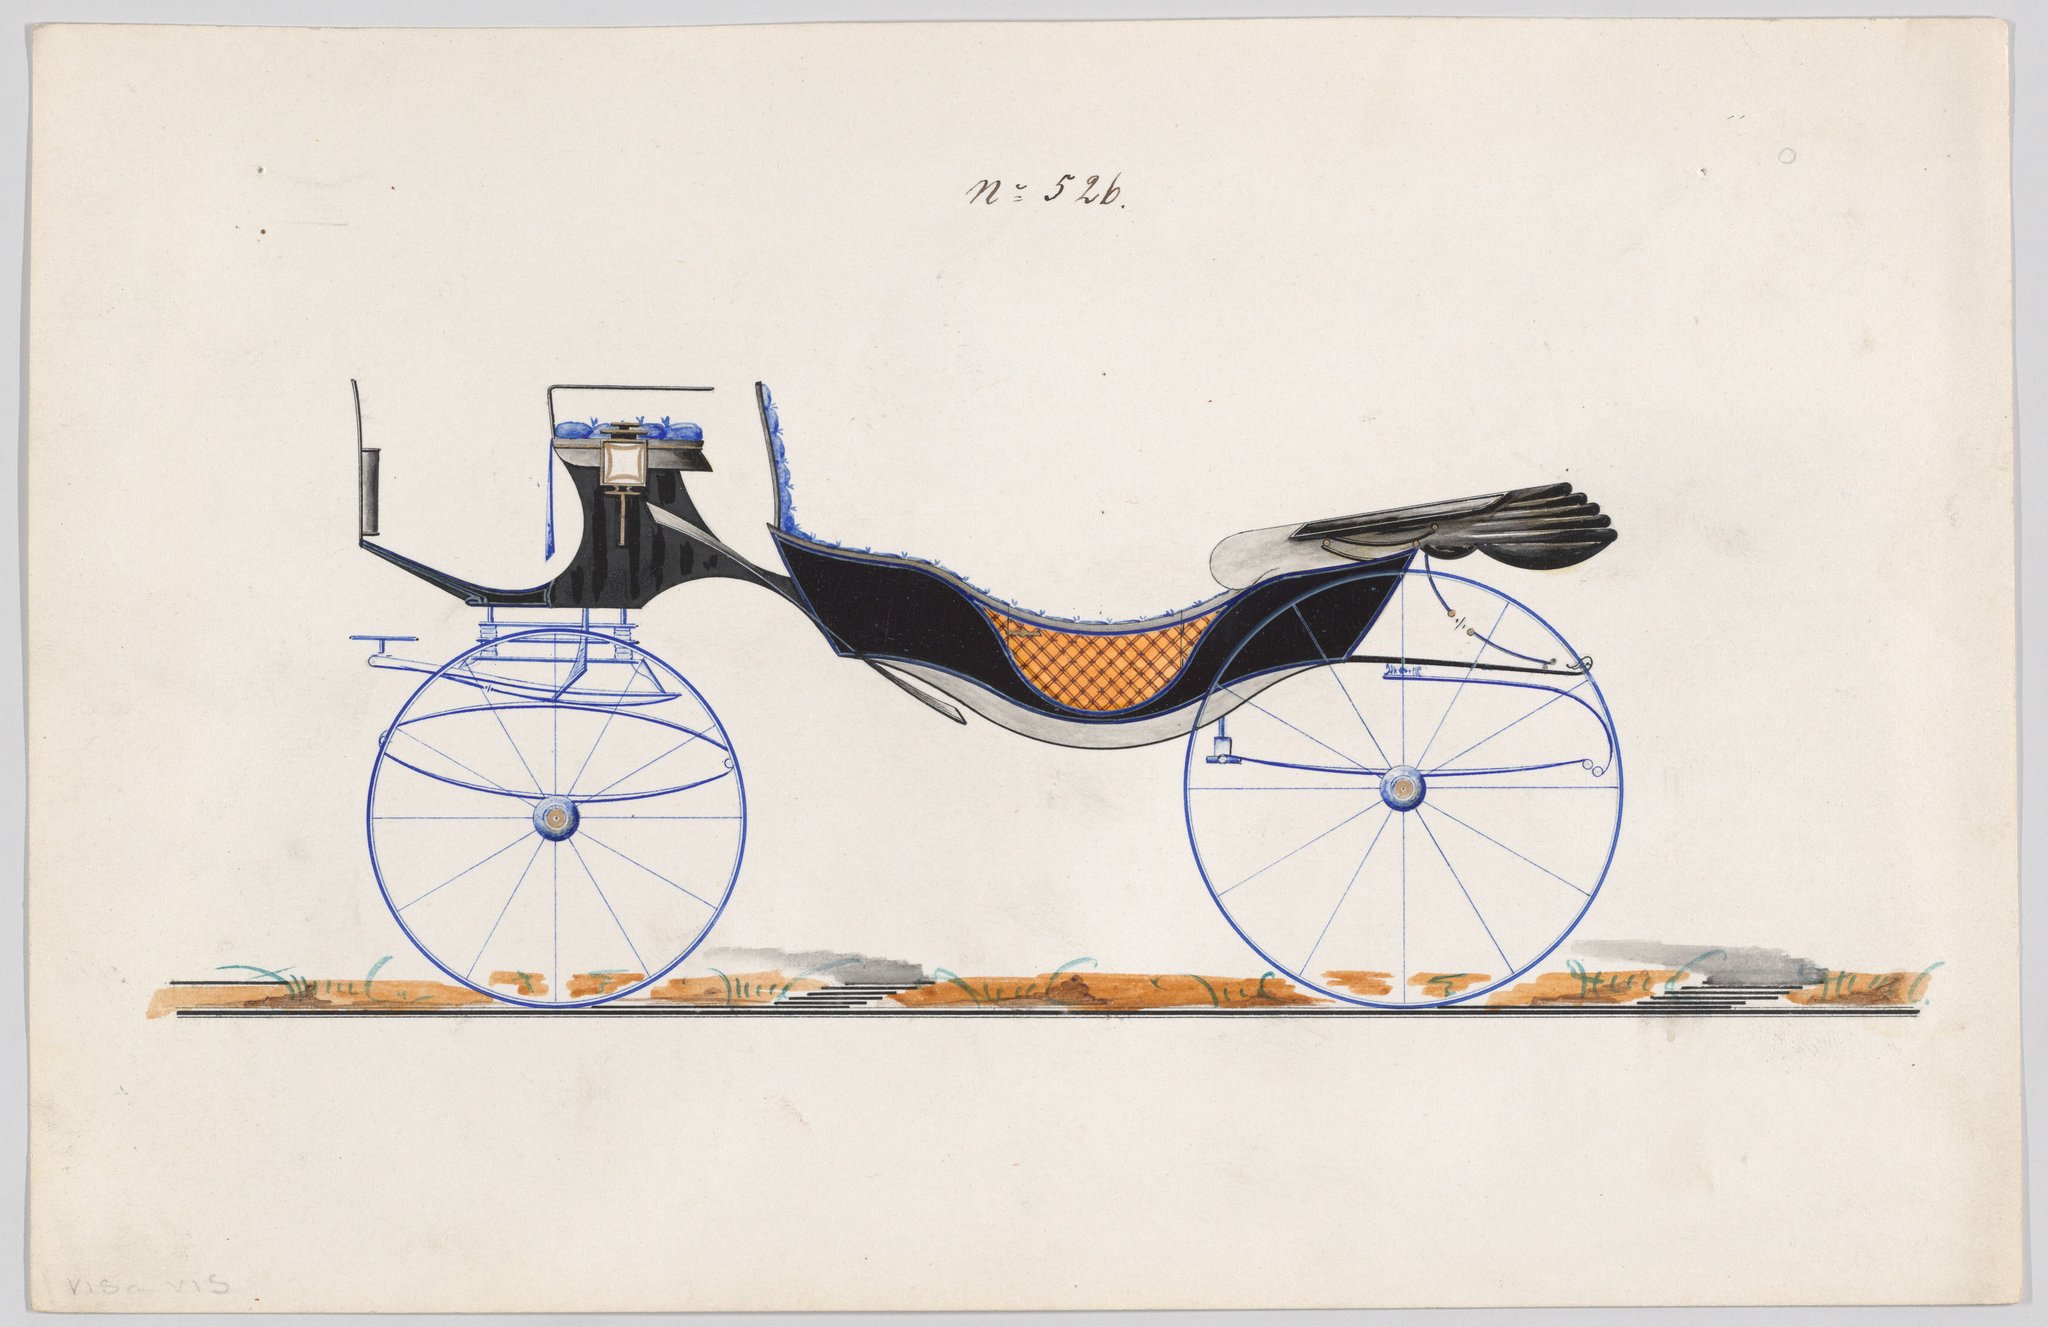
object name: drawing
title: Design for Vis-à-vis, no. 526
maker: brewster & co.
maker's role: manufacturer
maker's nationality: american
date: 1850-1870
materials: gouache, gum arabic, ink, watercolor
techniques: pen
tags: carriages